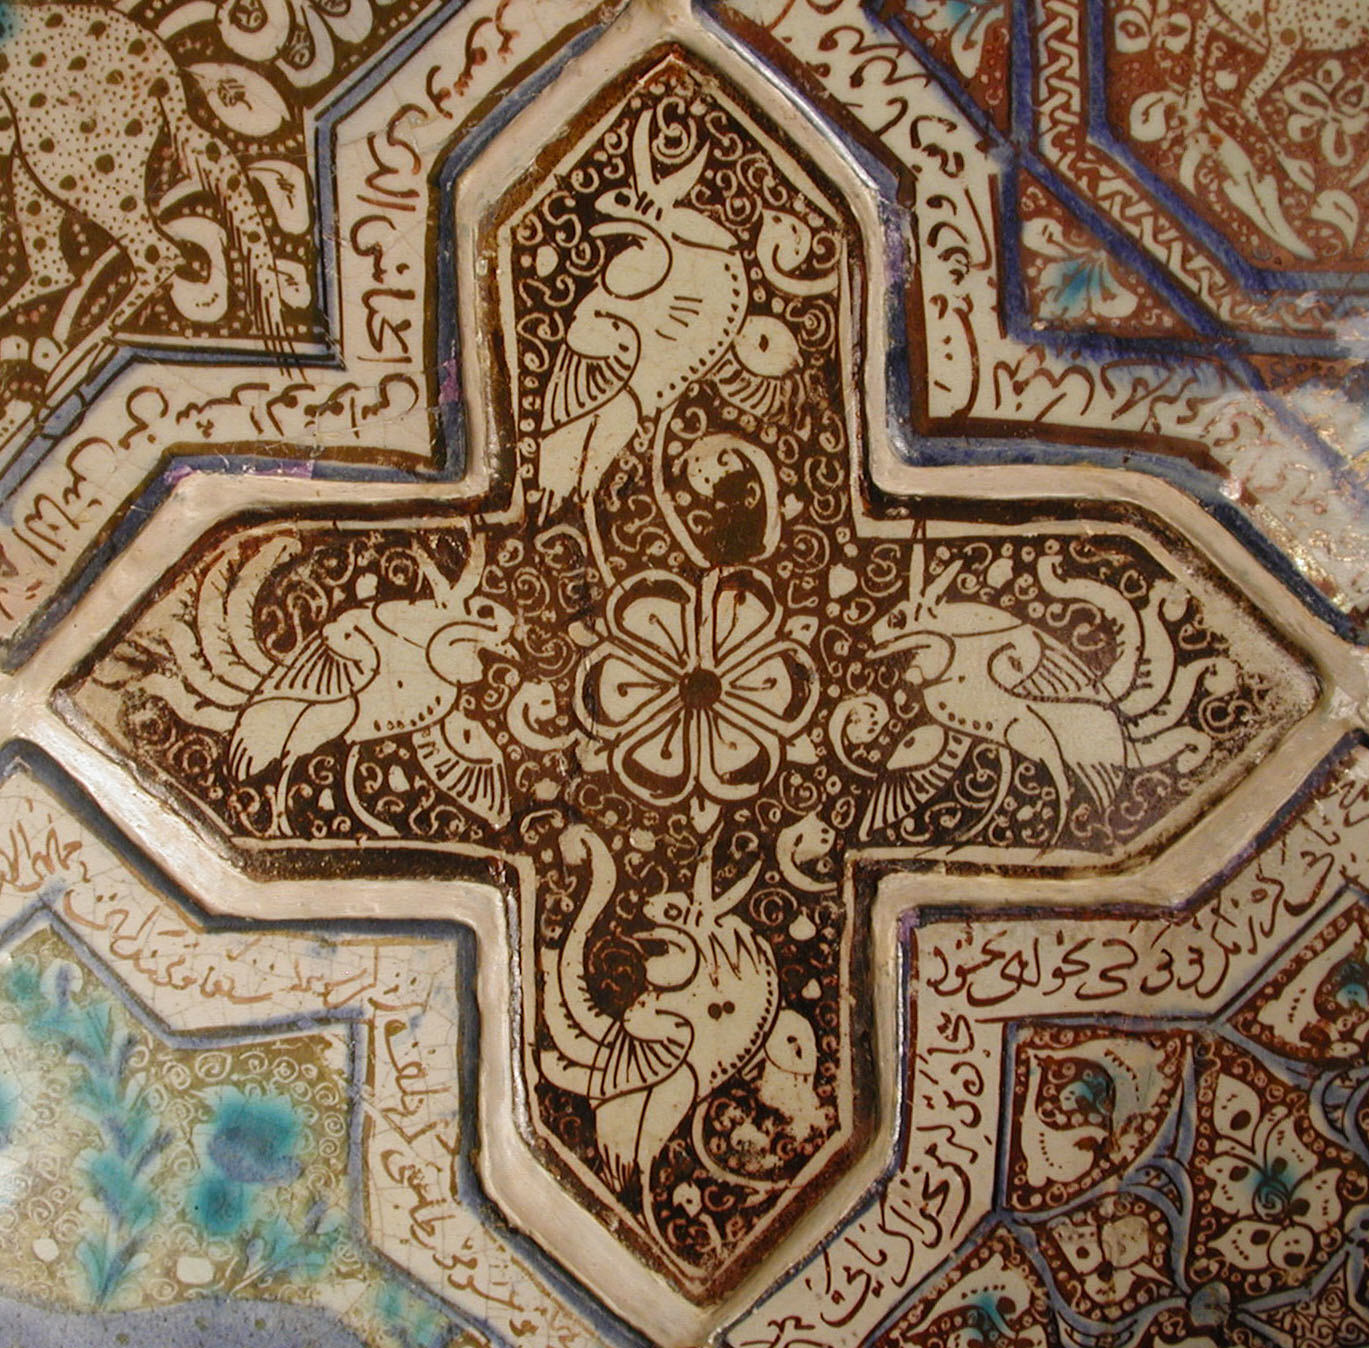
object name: tile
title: Cross-Shaped Tile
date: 1201-1300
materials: glaze, stonepaste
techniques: luster painting, painting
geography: iran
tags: birds